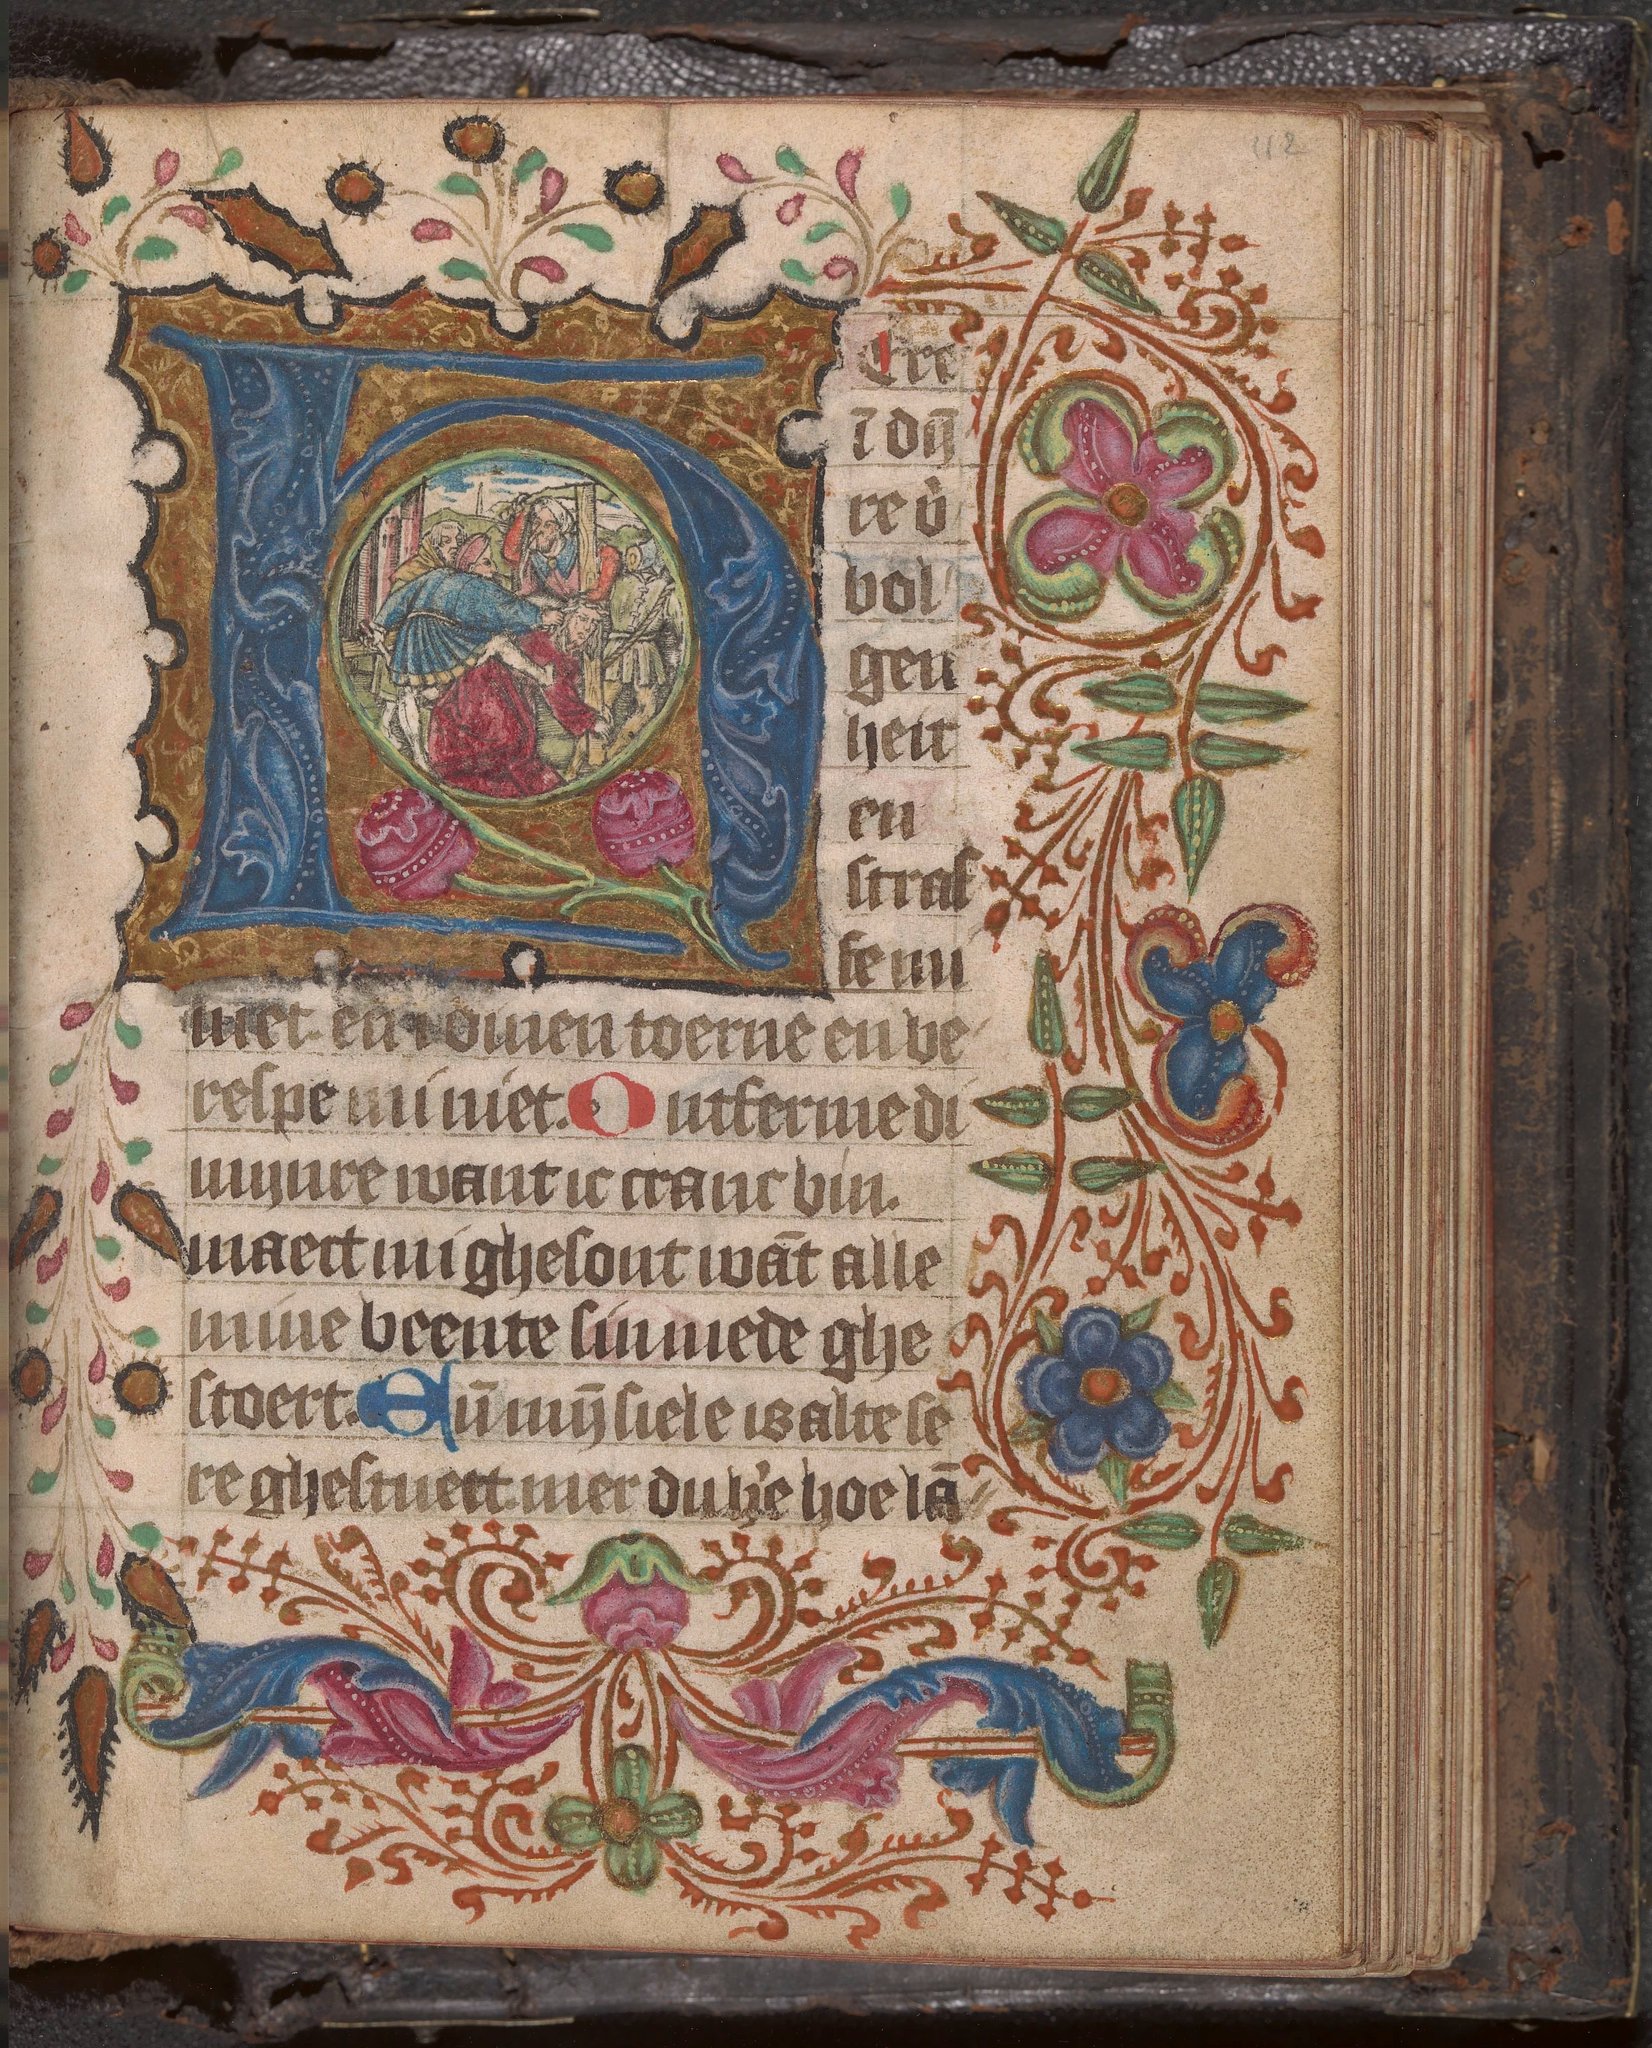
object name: book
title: Getijdenboek met zeven gehistoriseerde initialen waarbij in het oog van de initialen gravures zijn geplakt, met gedecoreerde initialen en penwerk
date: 1475-1500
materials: paint, gold leaf, ink, parchment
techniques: brush, engraving, pen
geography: netherlands